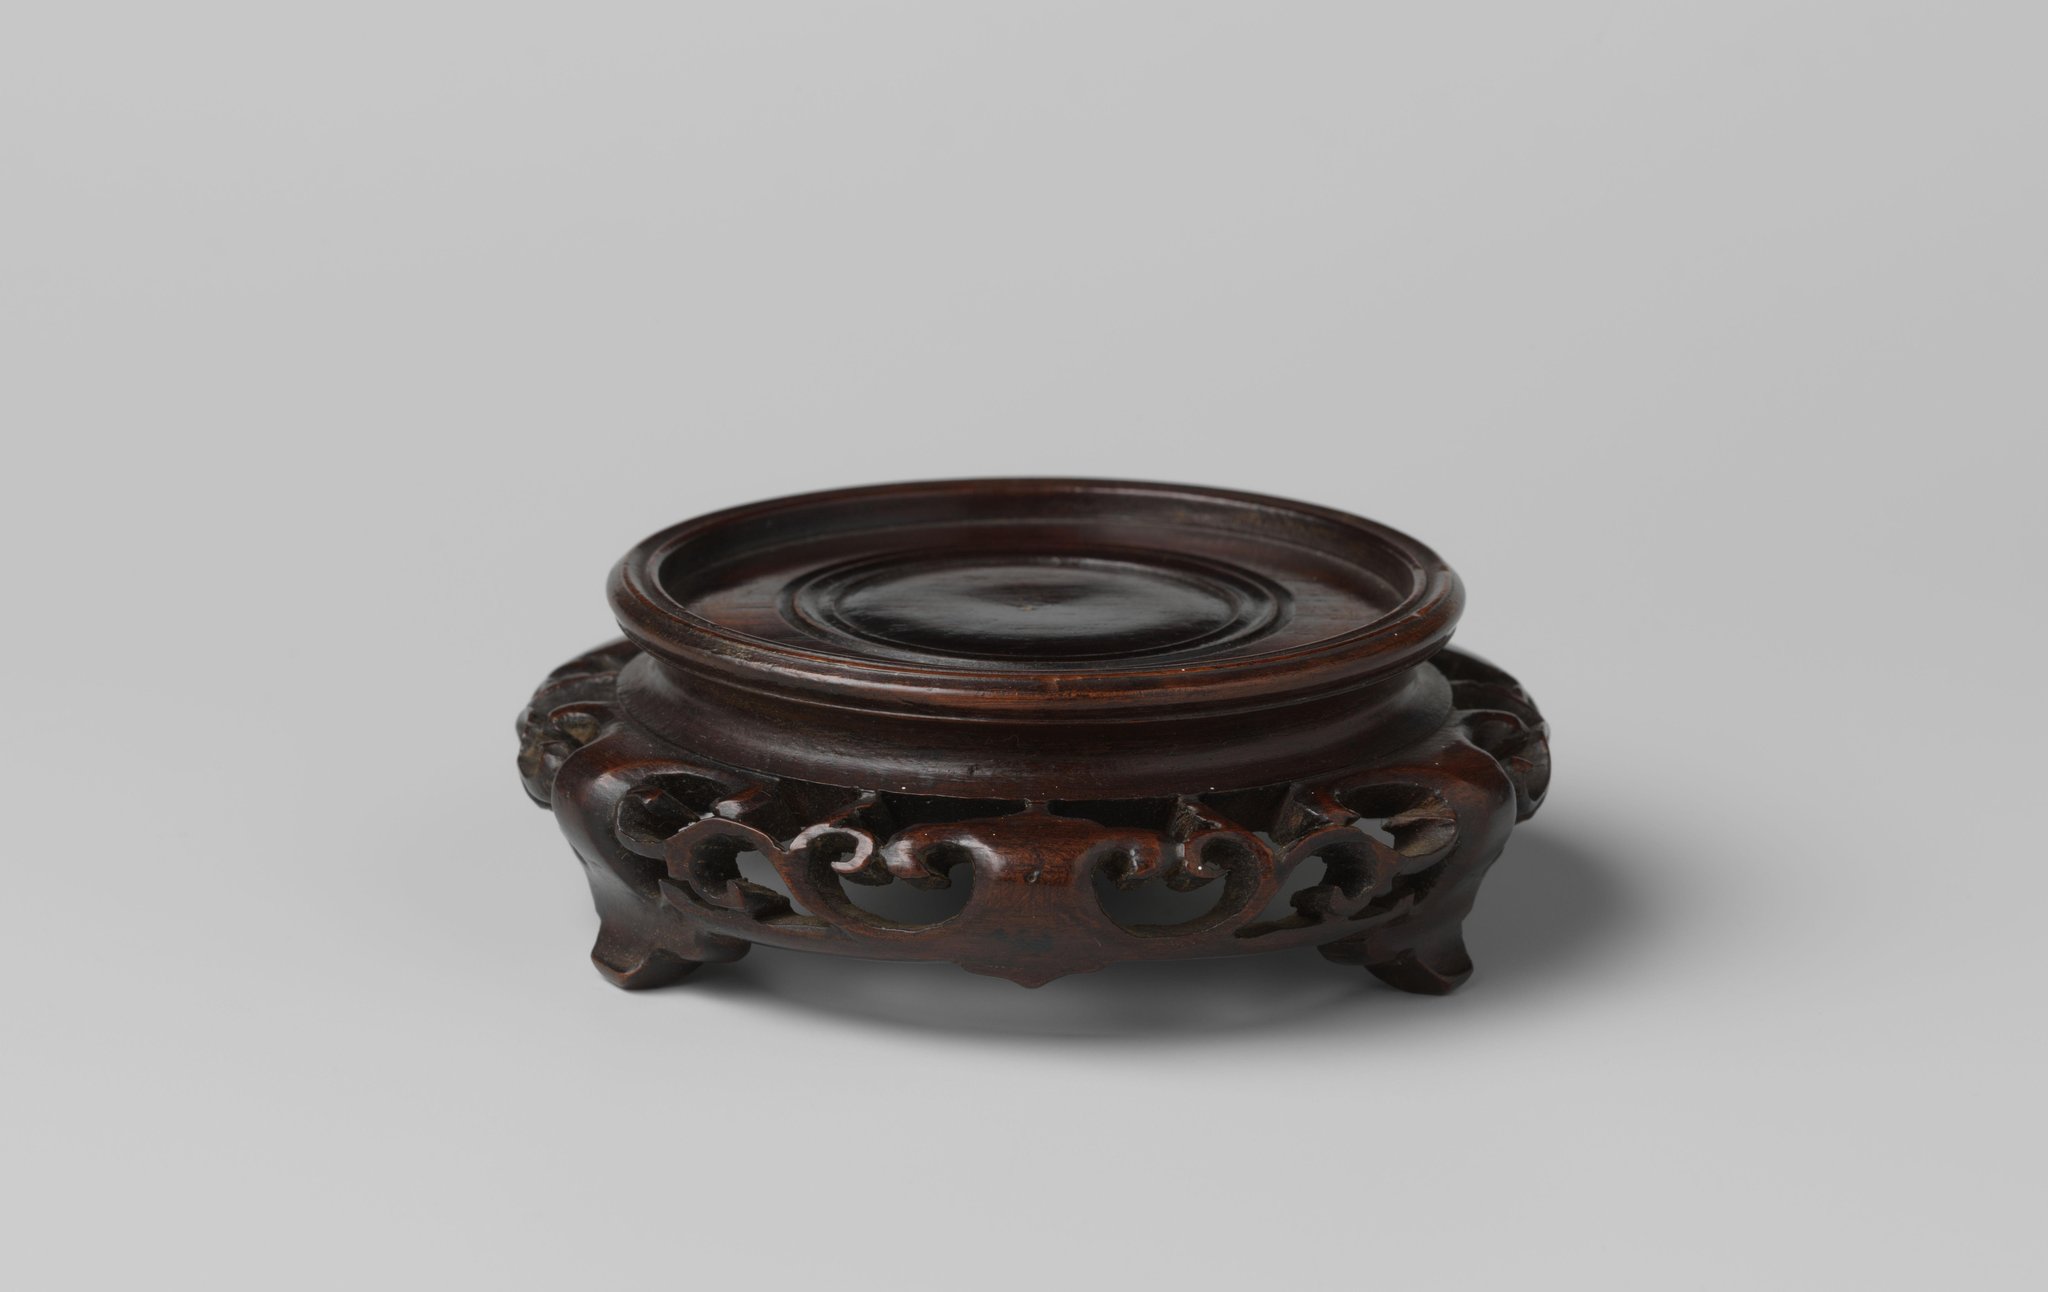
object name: foot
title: Voet behorende bij knobbelfles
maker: Anonymous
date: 1690-1710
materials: wood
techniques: processing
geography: china